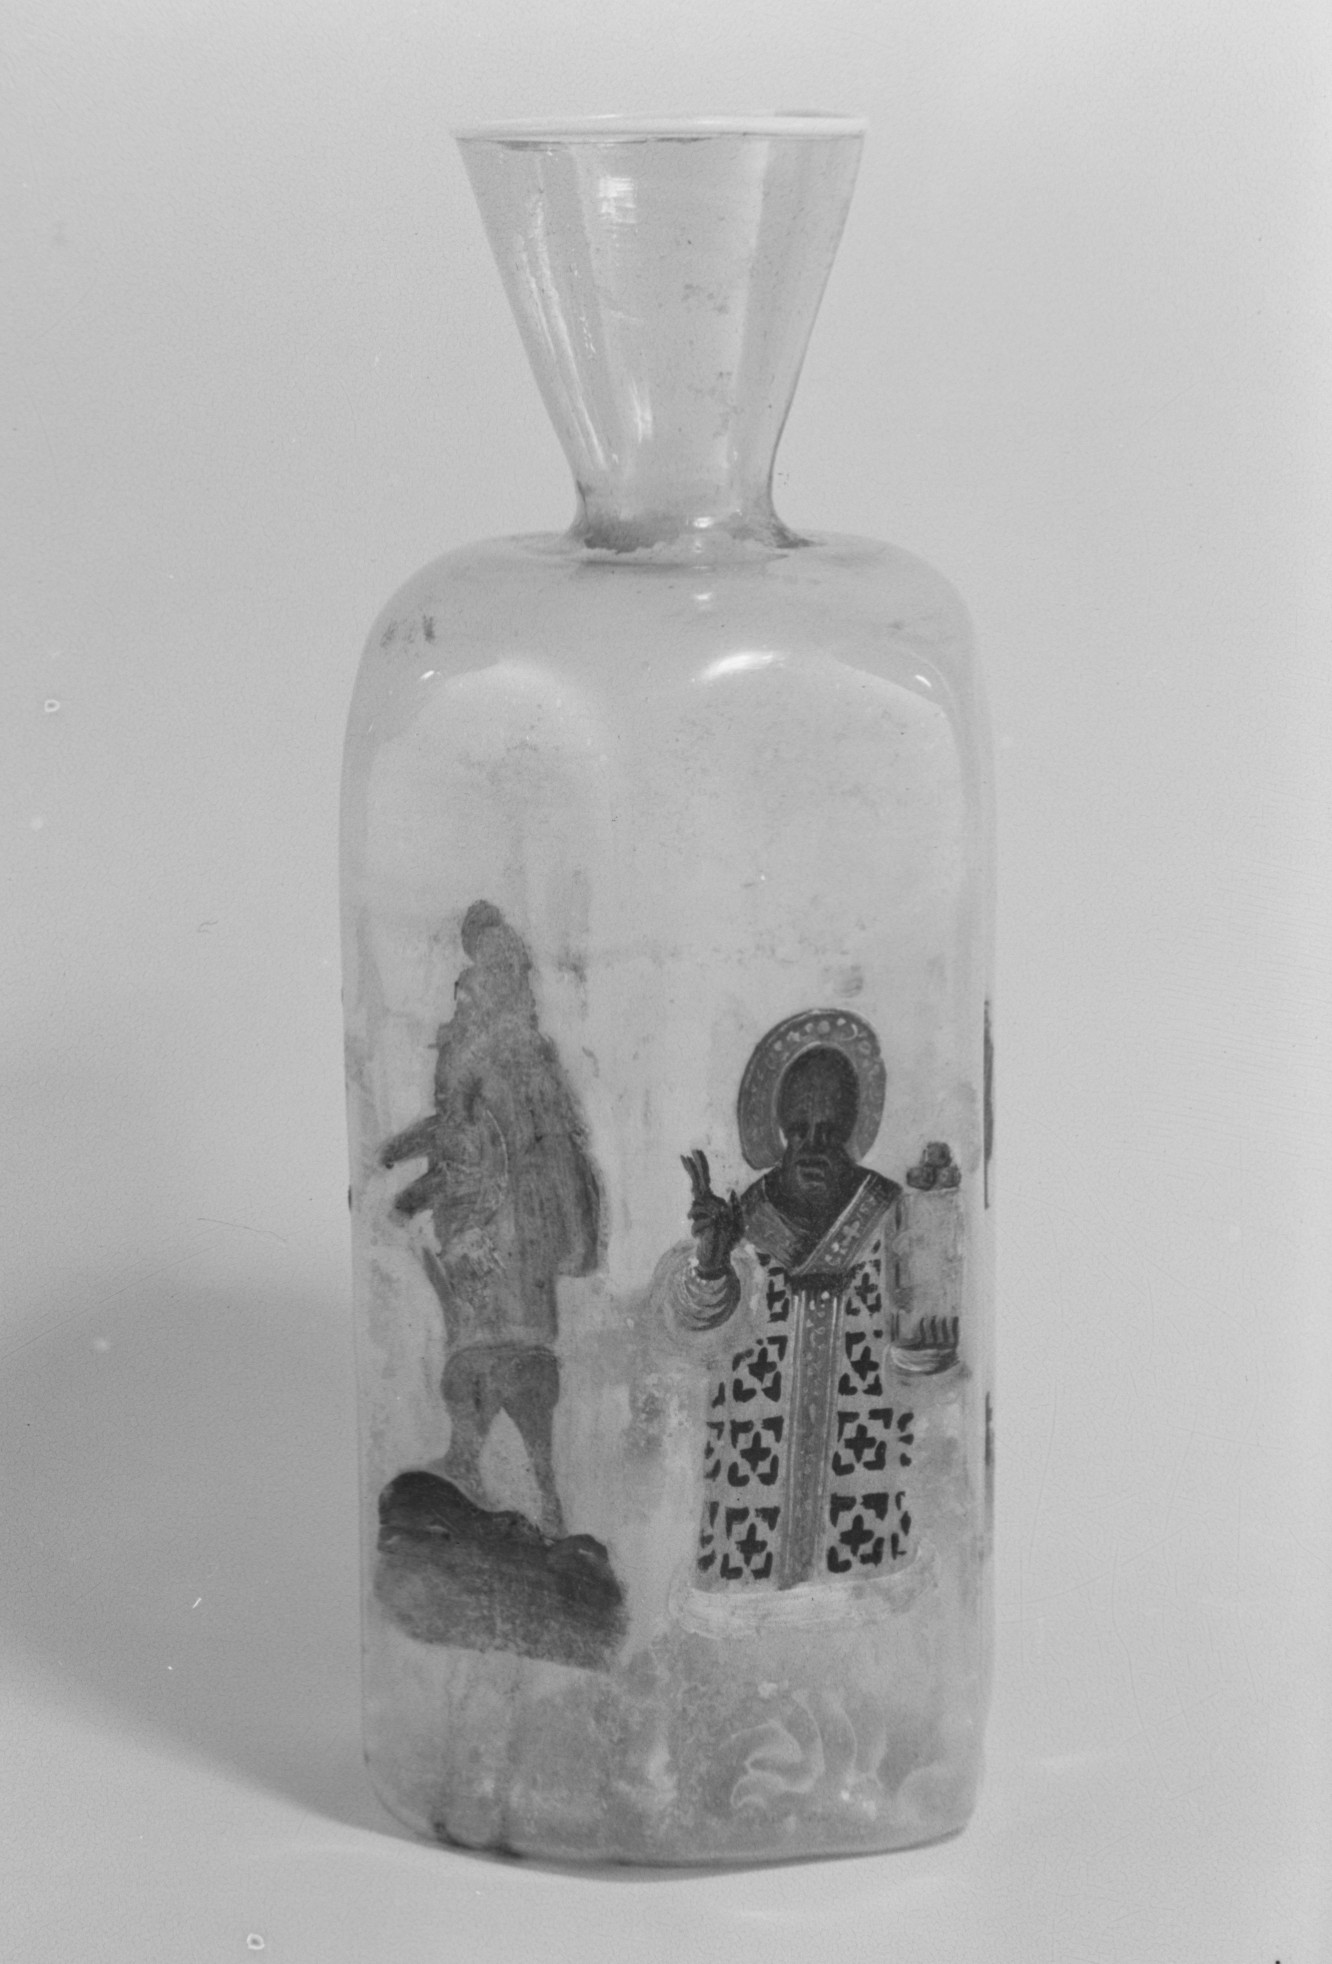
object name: bottle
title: Bottle with figure of St. Nicholas (?)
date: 1667-1733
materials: glass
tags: saints